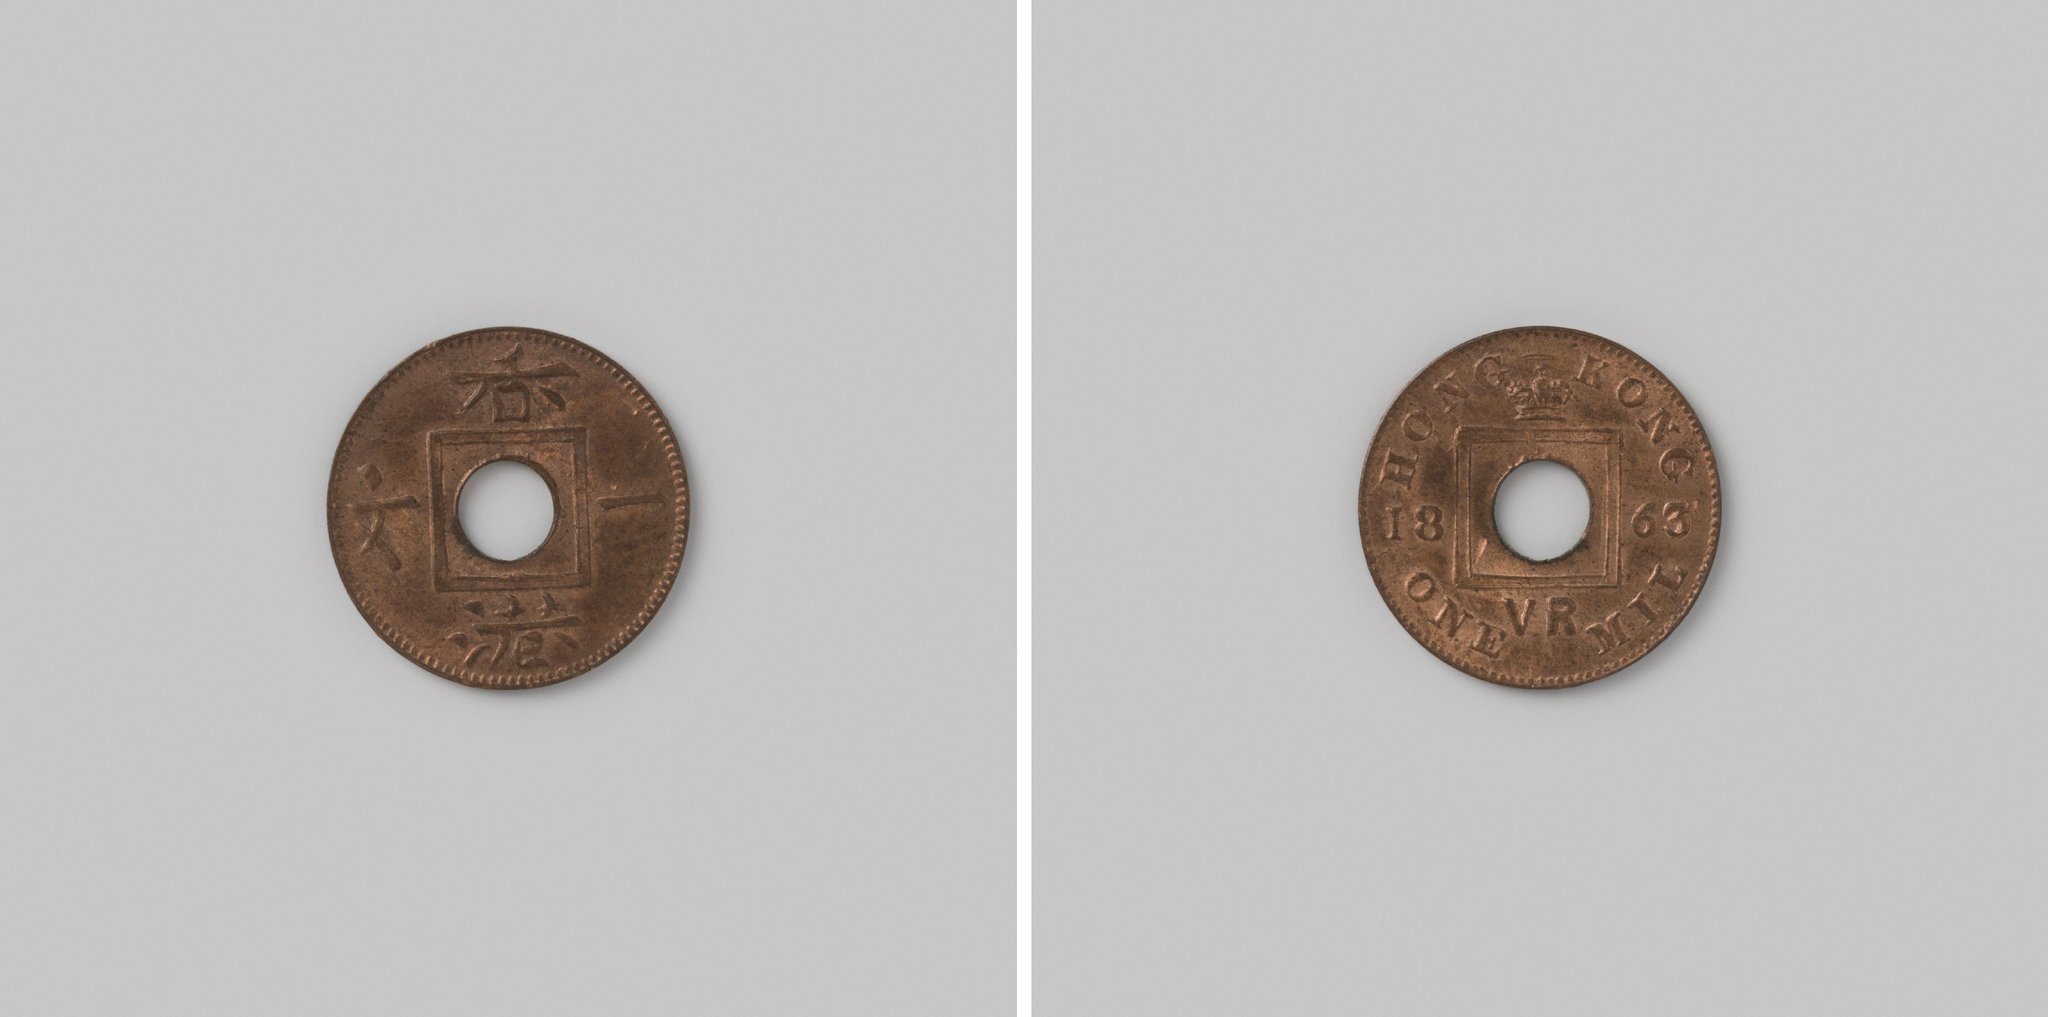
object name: coin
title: Mil of wen uit Hongkong van koningin Victoria, 1863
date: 1863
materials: bronze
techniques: striking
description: Bronzen munt. Voorzijde: rondom ronde uitsparing in het midden vier kruisgewijze geplaatste Chinese tekens, waaronder rechts liggende streep [=een]. Keerzijde: rondom uitsparing in het midden jaartal. Onderaan waarde-aanduiding: one mil, waarboven de letters VR [=Victoria Regina]. Gladde rand.